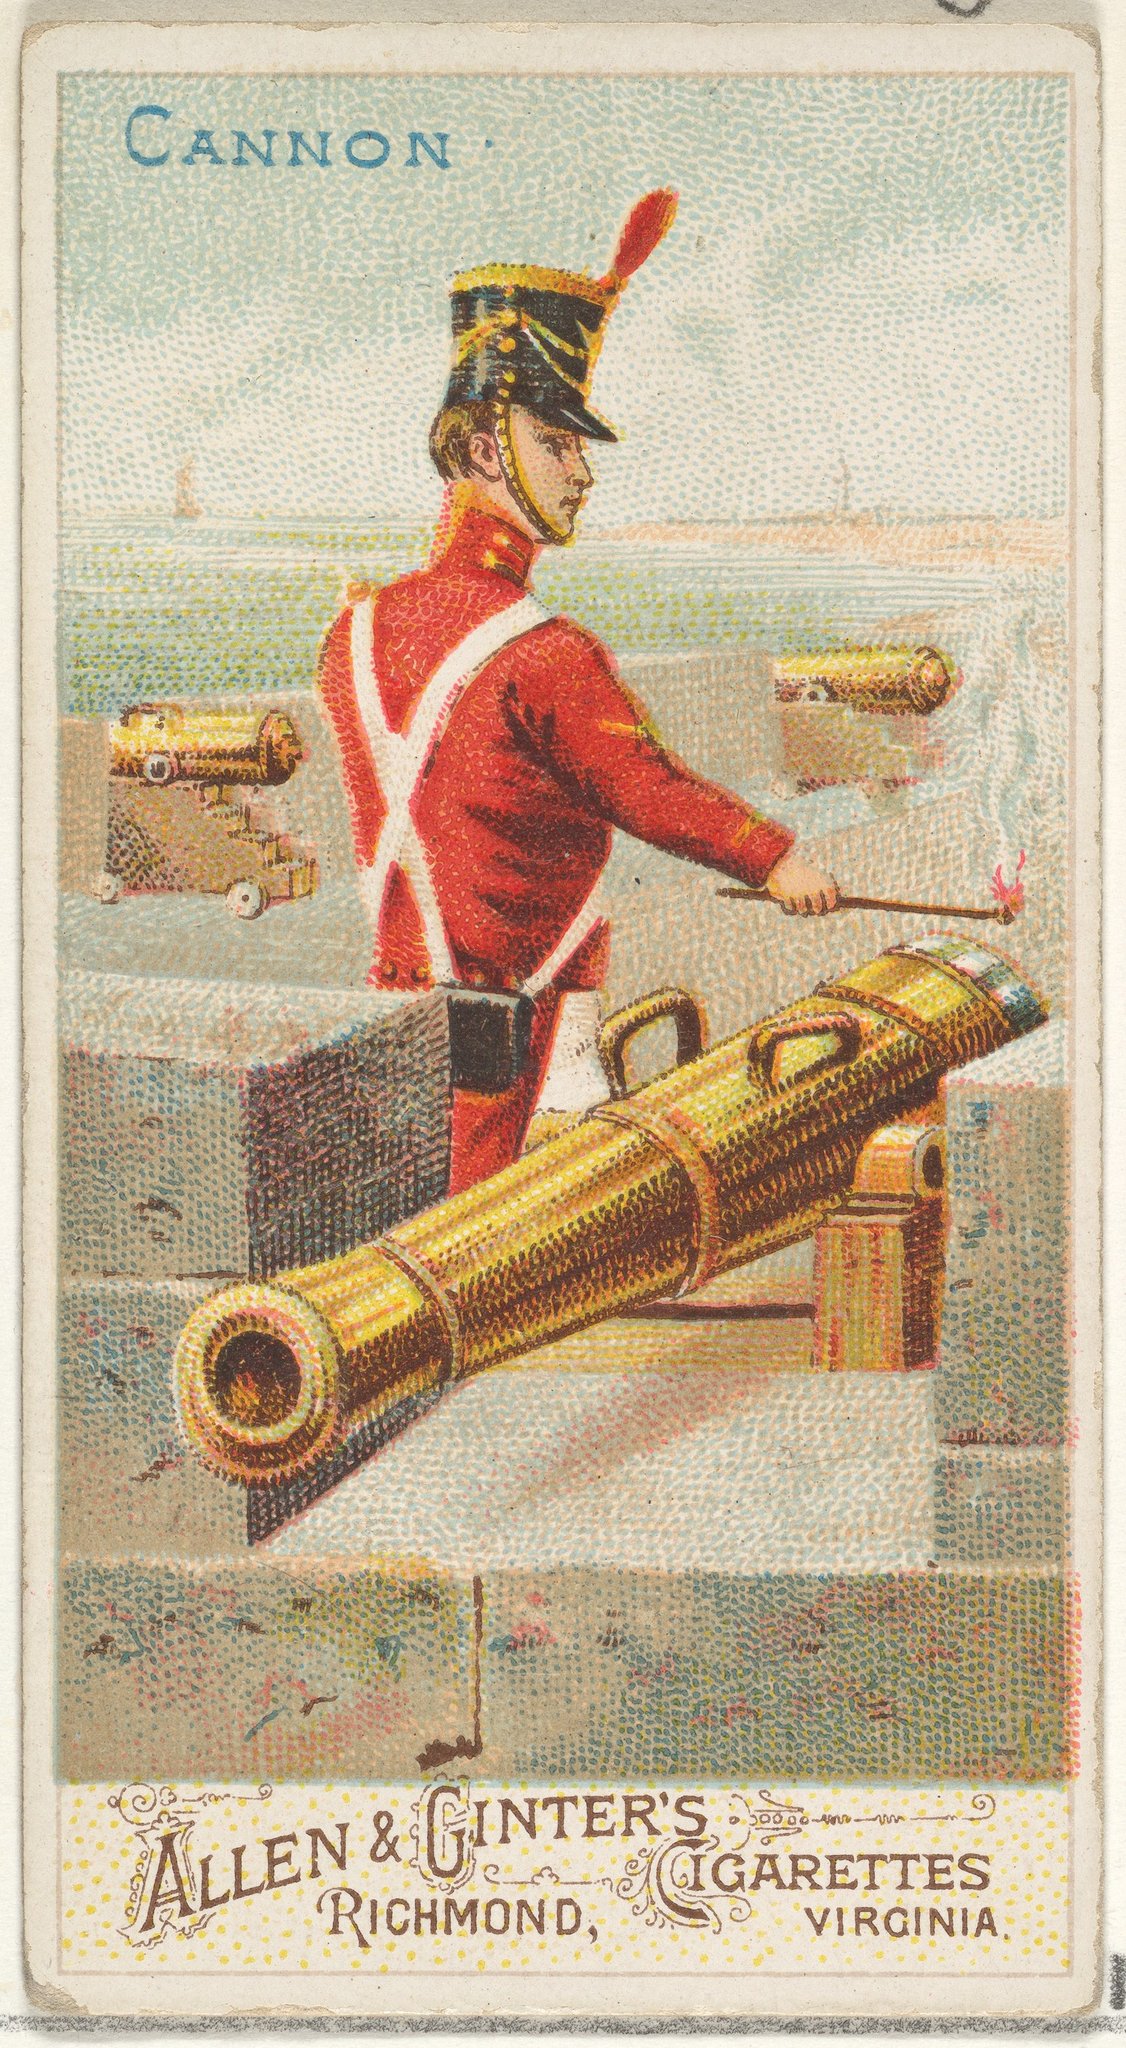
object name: print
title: Cannon, from the Arms of All Nations series (N3) for Allen & Ginter Cigarettes Brands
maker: allen & ginter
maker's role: publisher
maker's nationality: american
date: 1887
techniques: color lithograph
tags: soldiers,cannons,men,profiles